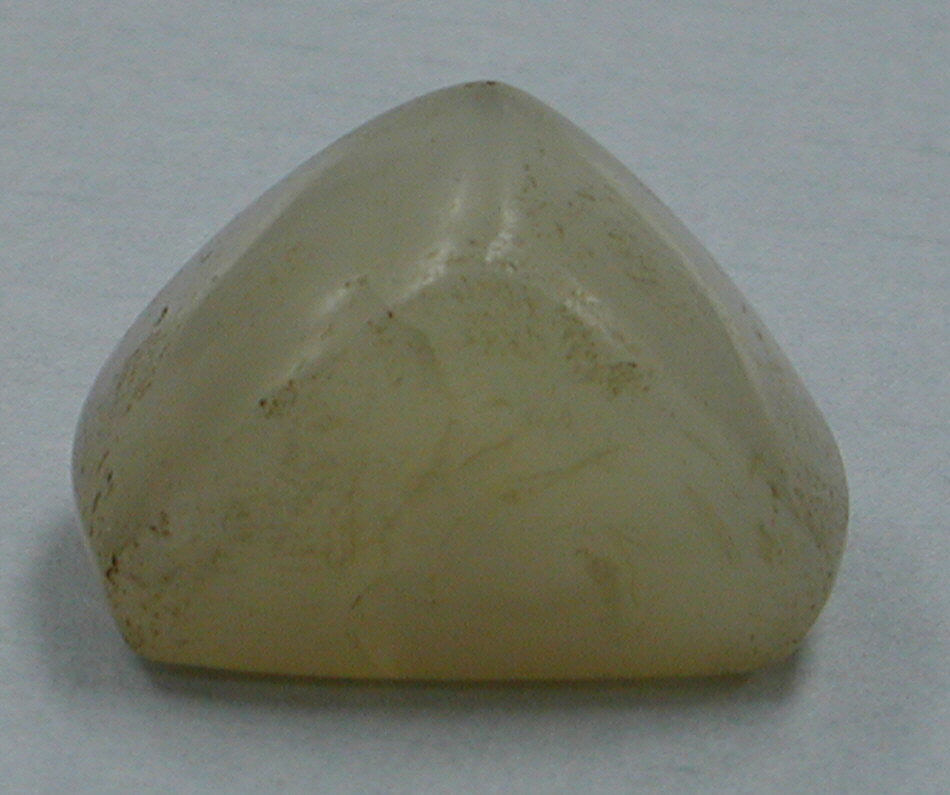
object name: ritual stone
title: Stone Pulidor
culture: mexican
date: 1501-1600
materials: stone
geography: mexico